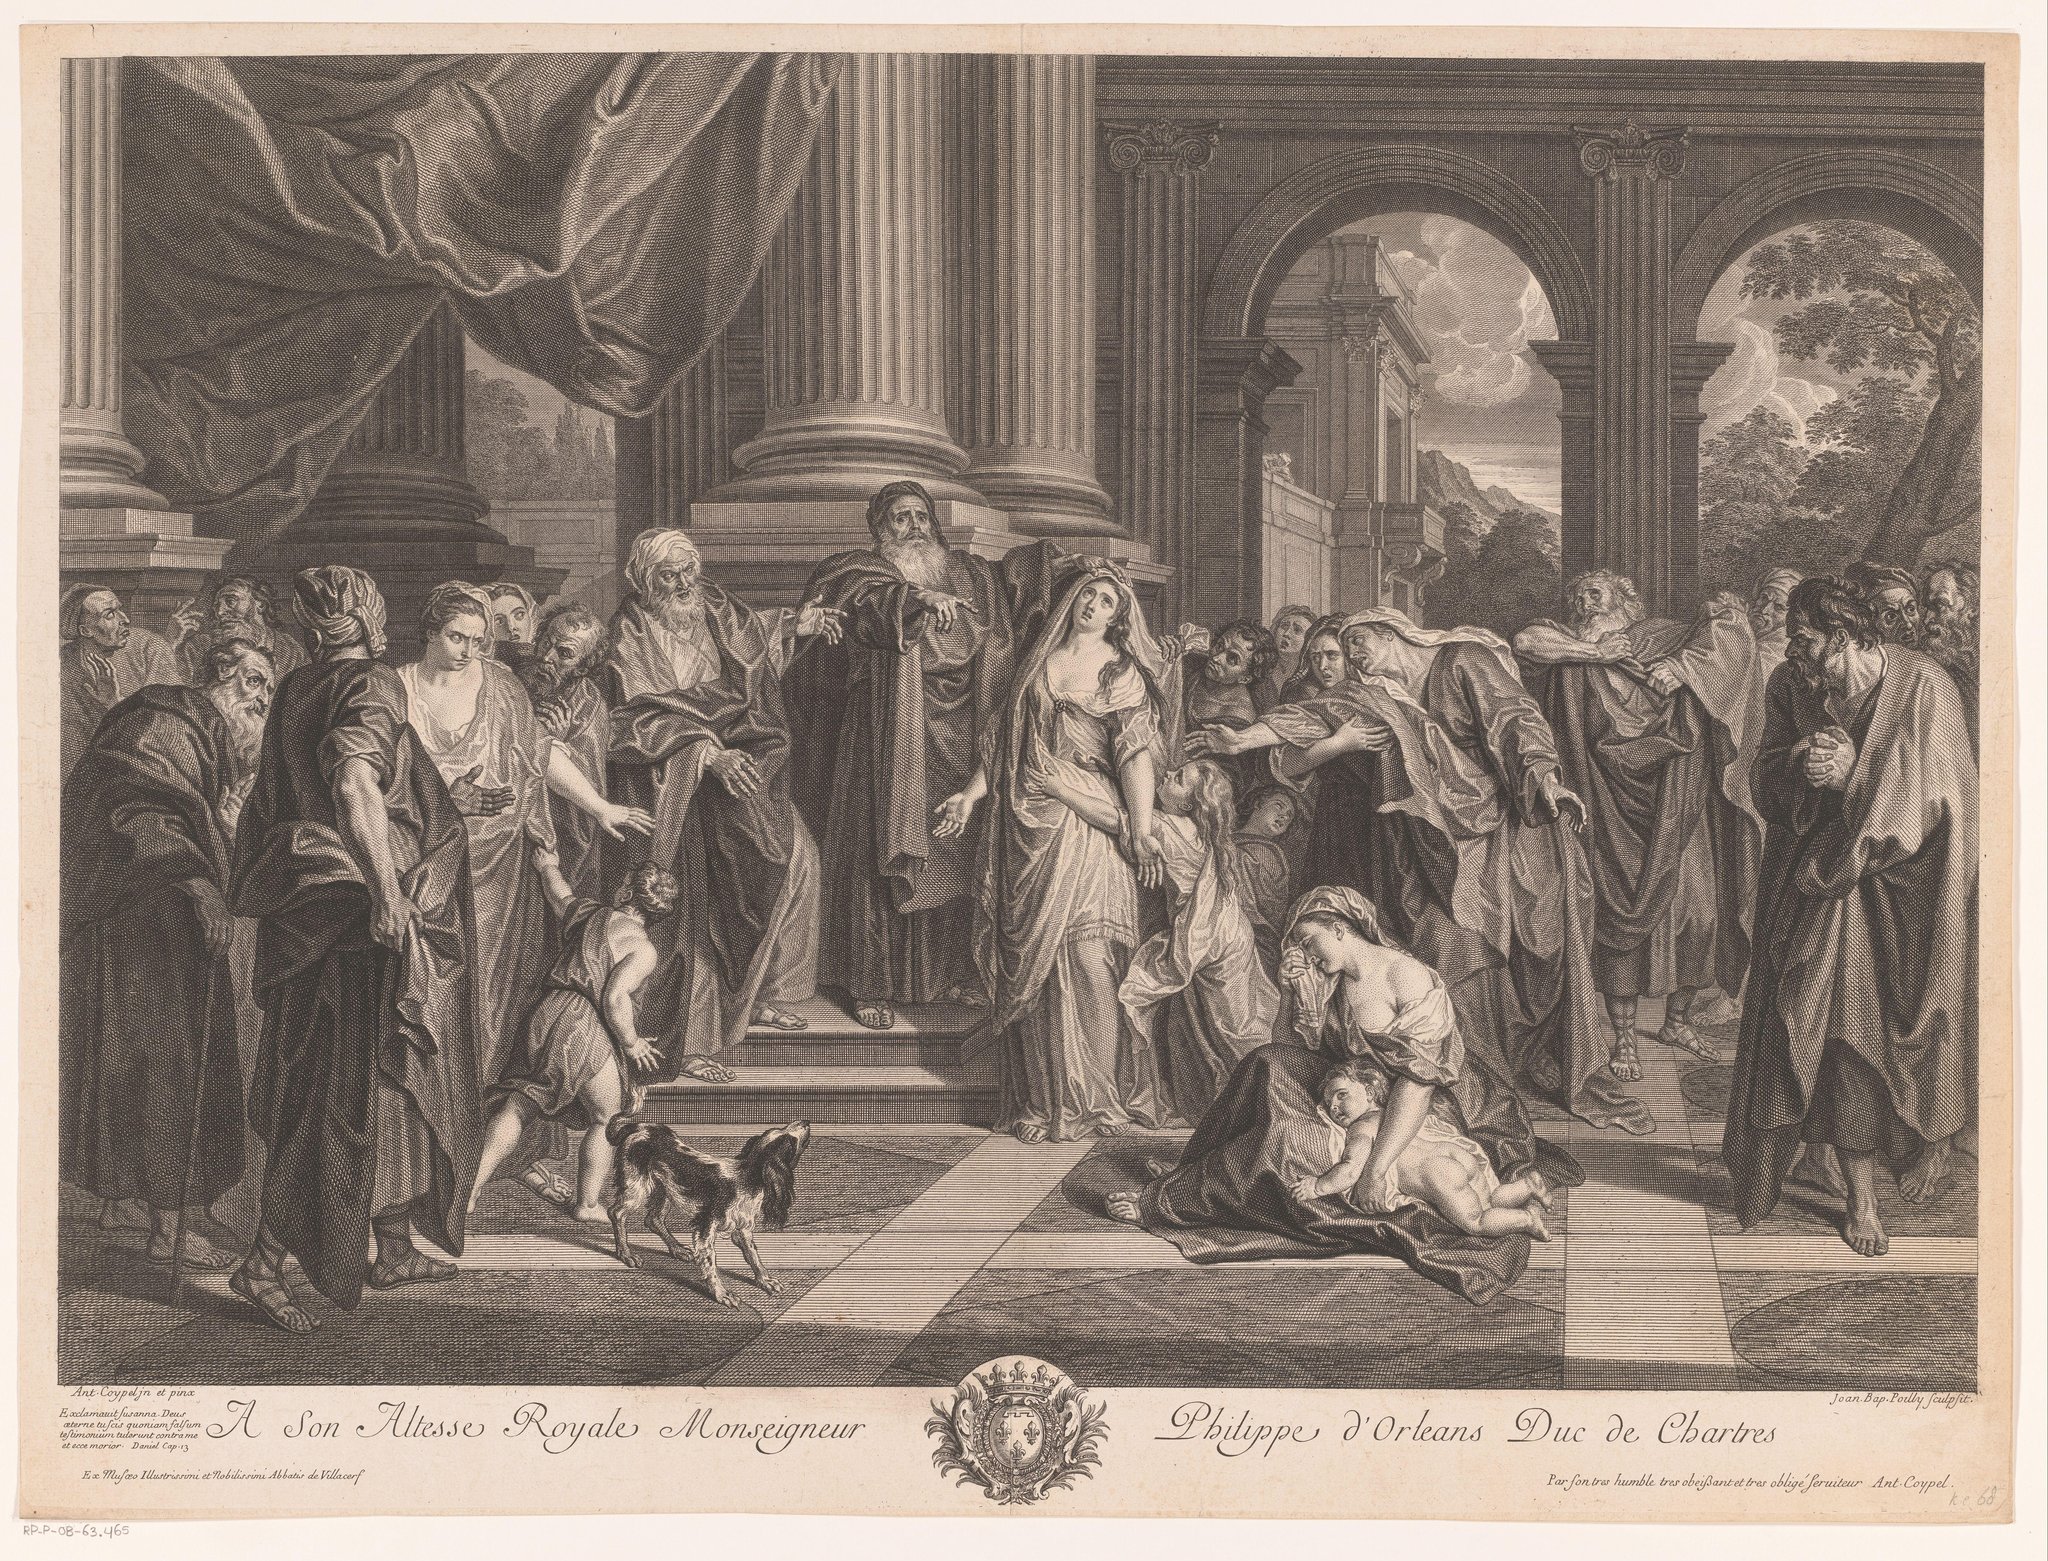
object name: print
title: Susanna beschuldigd door de ouderlingen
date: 1679-1722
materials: paper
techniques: engraving, etching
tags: the elders accusing susanna before the people, laying their hands on her head or unveiling her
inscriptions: collector's mark: Lugt 240